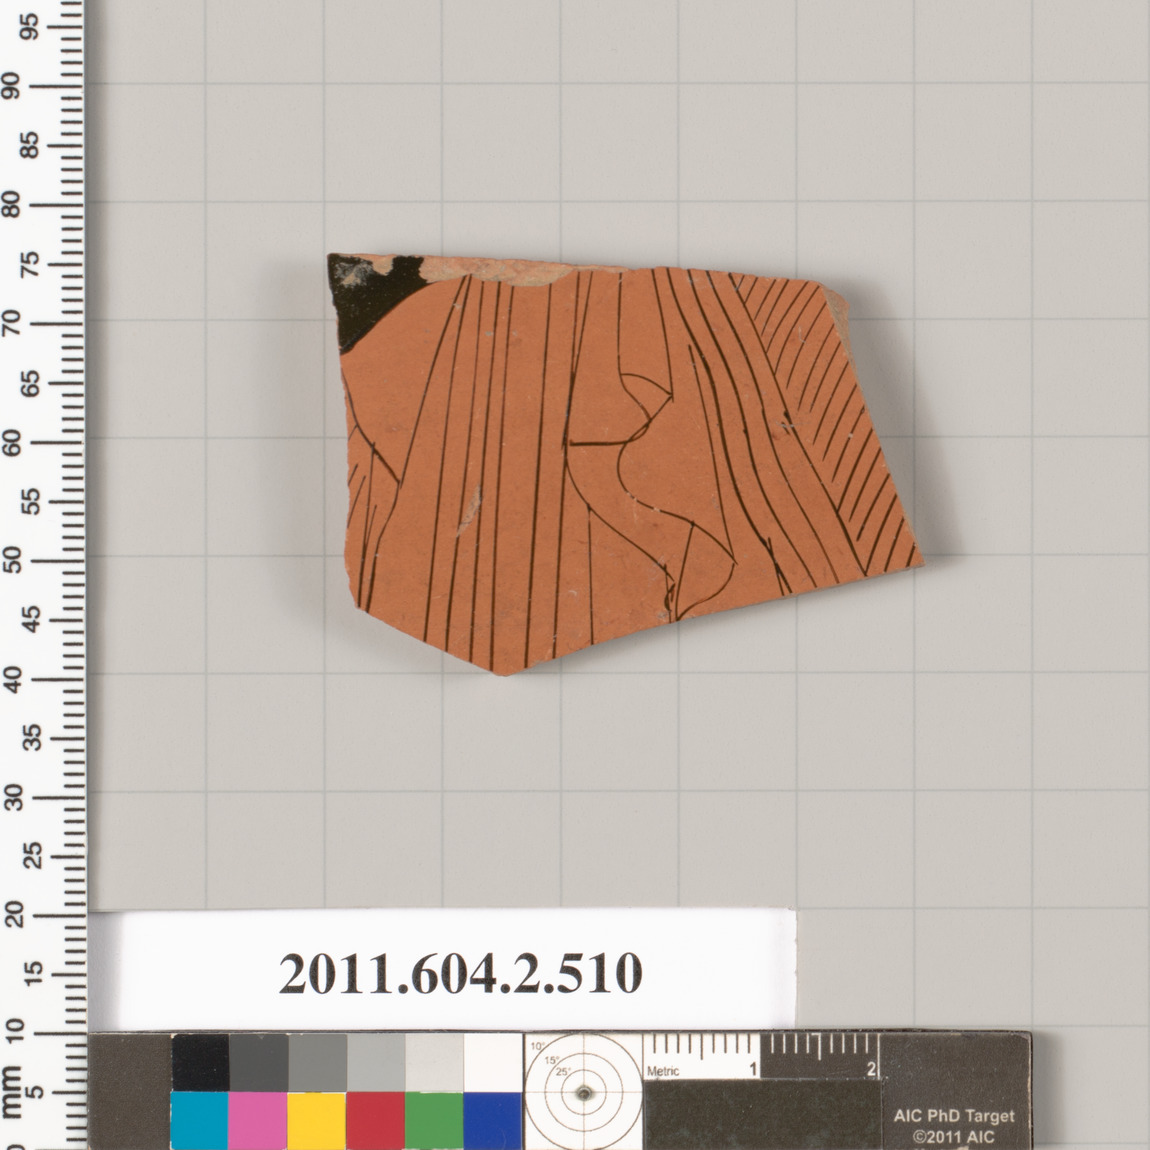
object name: column krater fragment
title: Terracotta fragment of a column-krater (bowl for mixing wine and water)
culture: greek, attic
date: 475-451 BCE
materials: terracotta